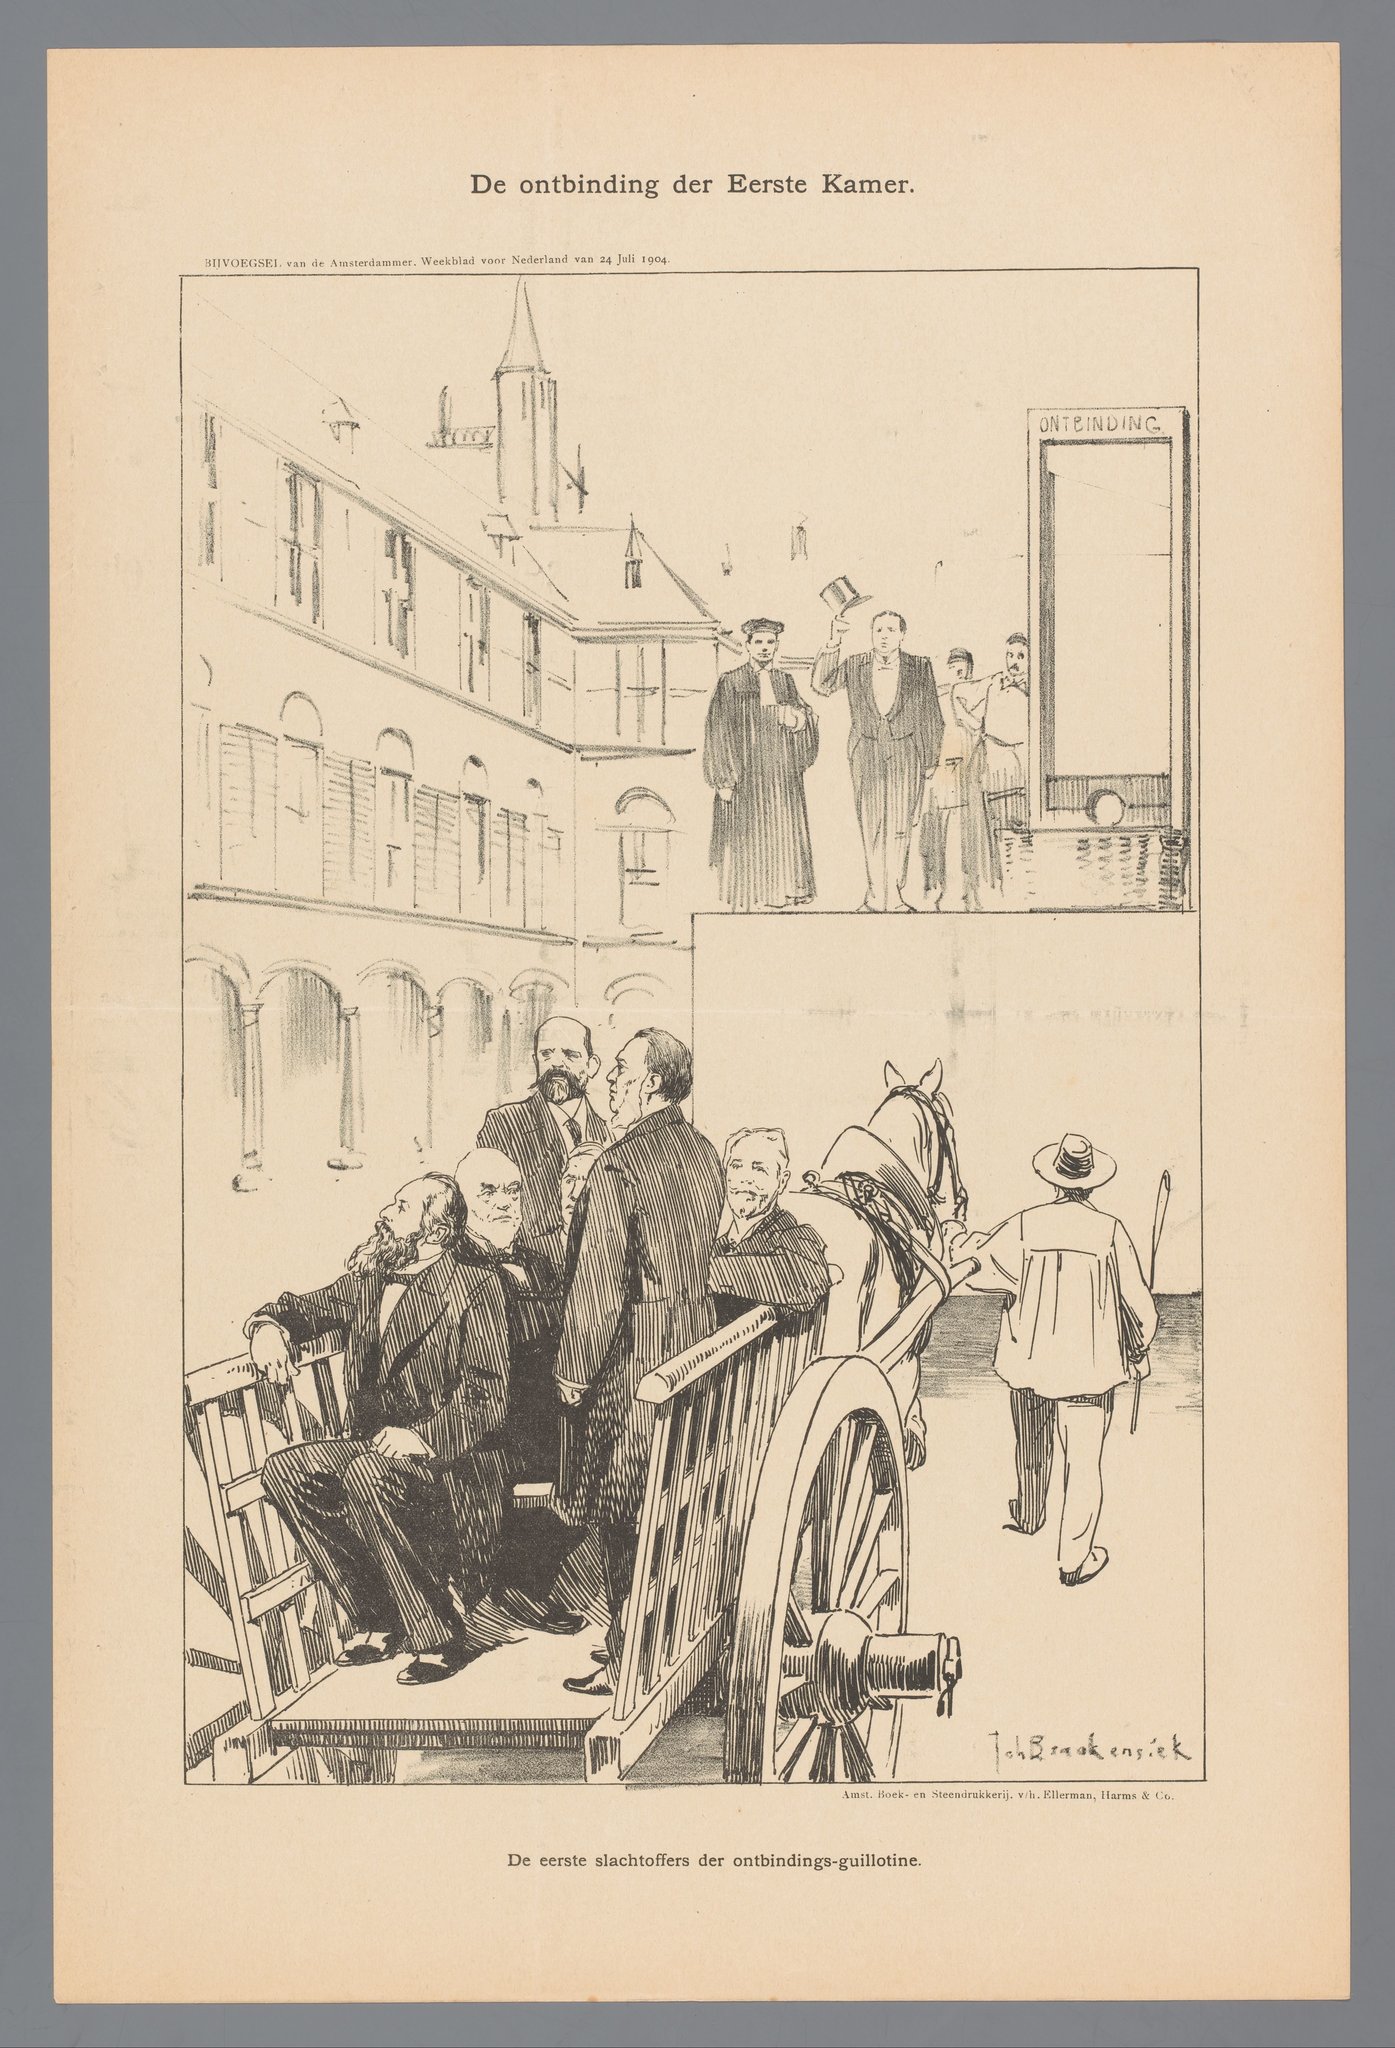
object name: cartoon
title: De ontbinding der Eerste Kamer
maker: johan braakensiek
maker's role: draughtsman, print maker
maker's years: 1858-1940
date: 1904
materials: paper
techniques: lithograph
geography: amsterdam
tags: the hague, abraham kuyper, violent death ~ beheading by guillotine, political caricatures and satires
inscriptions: date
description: Prent uit het bijvoegsel van: De Amsterdammer. Weekblad voor Nederland, 24 juli 1904.